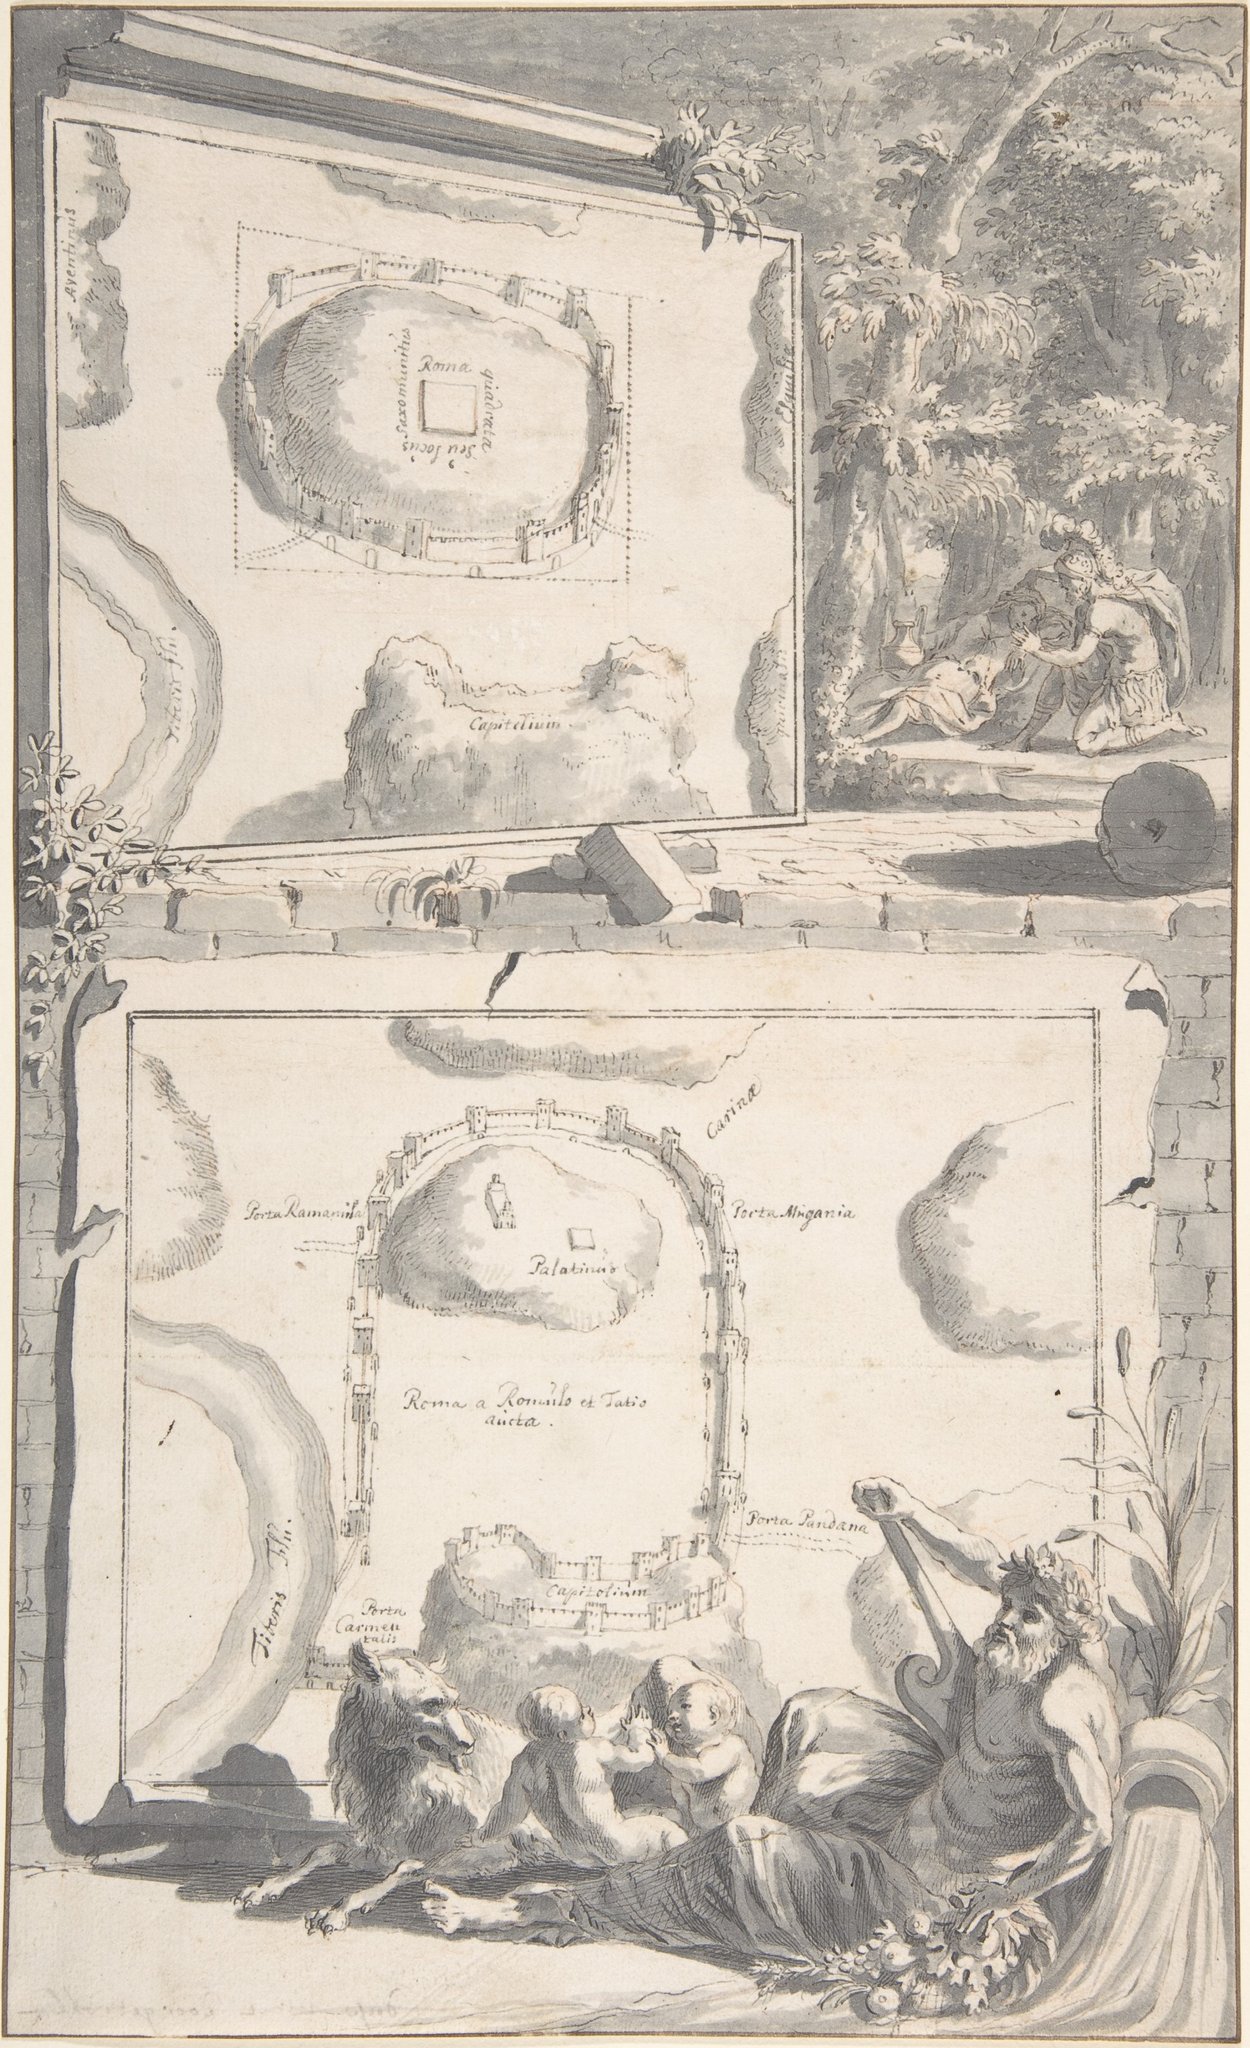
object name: drawing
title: Two Maps of Ancient Rome with a River God and Romulus and Remus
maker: jan goeree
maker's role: artist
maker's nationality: dutch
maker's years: 1670-1731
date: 1704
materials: chalk, ink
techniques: brush, incising, pen, wash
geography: italy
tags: animals,children,gods,maps